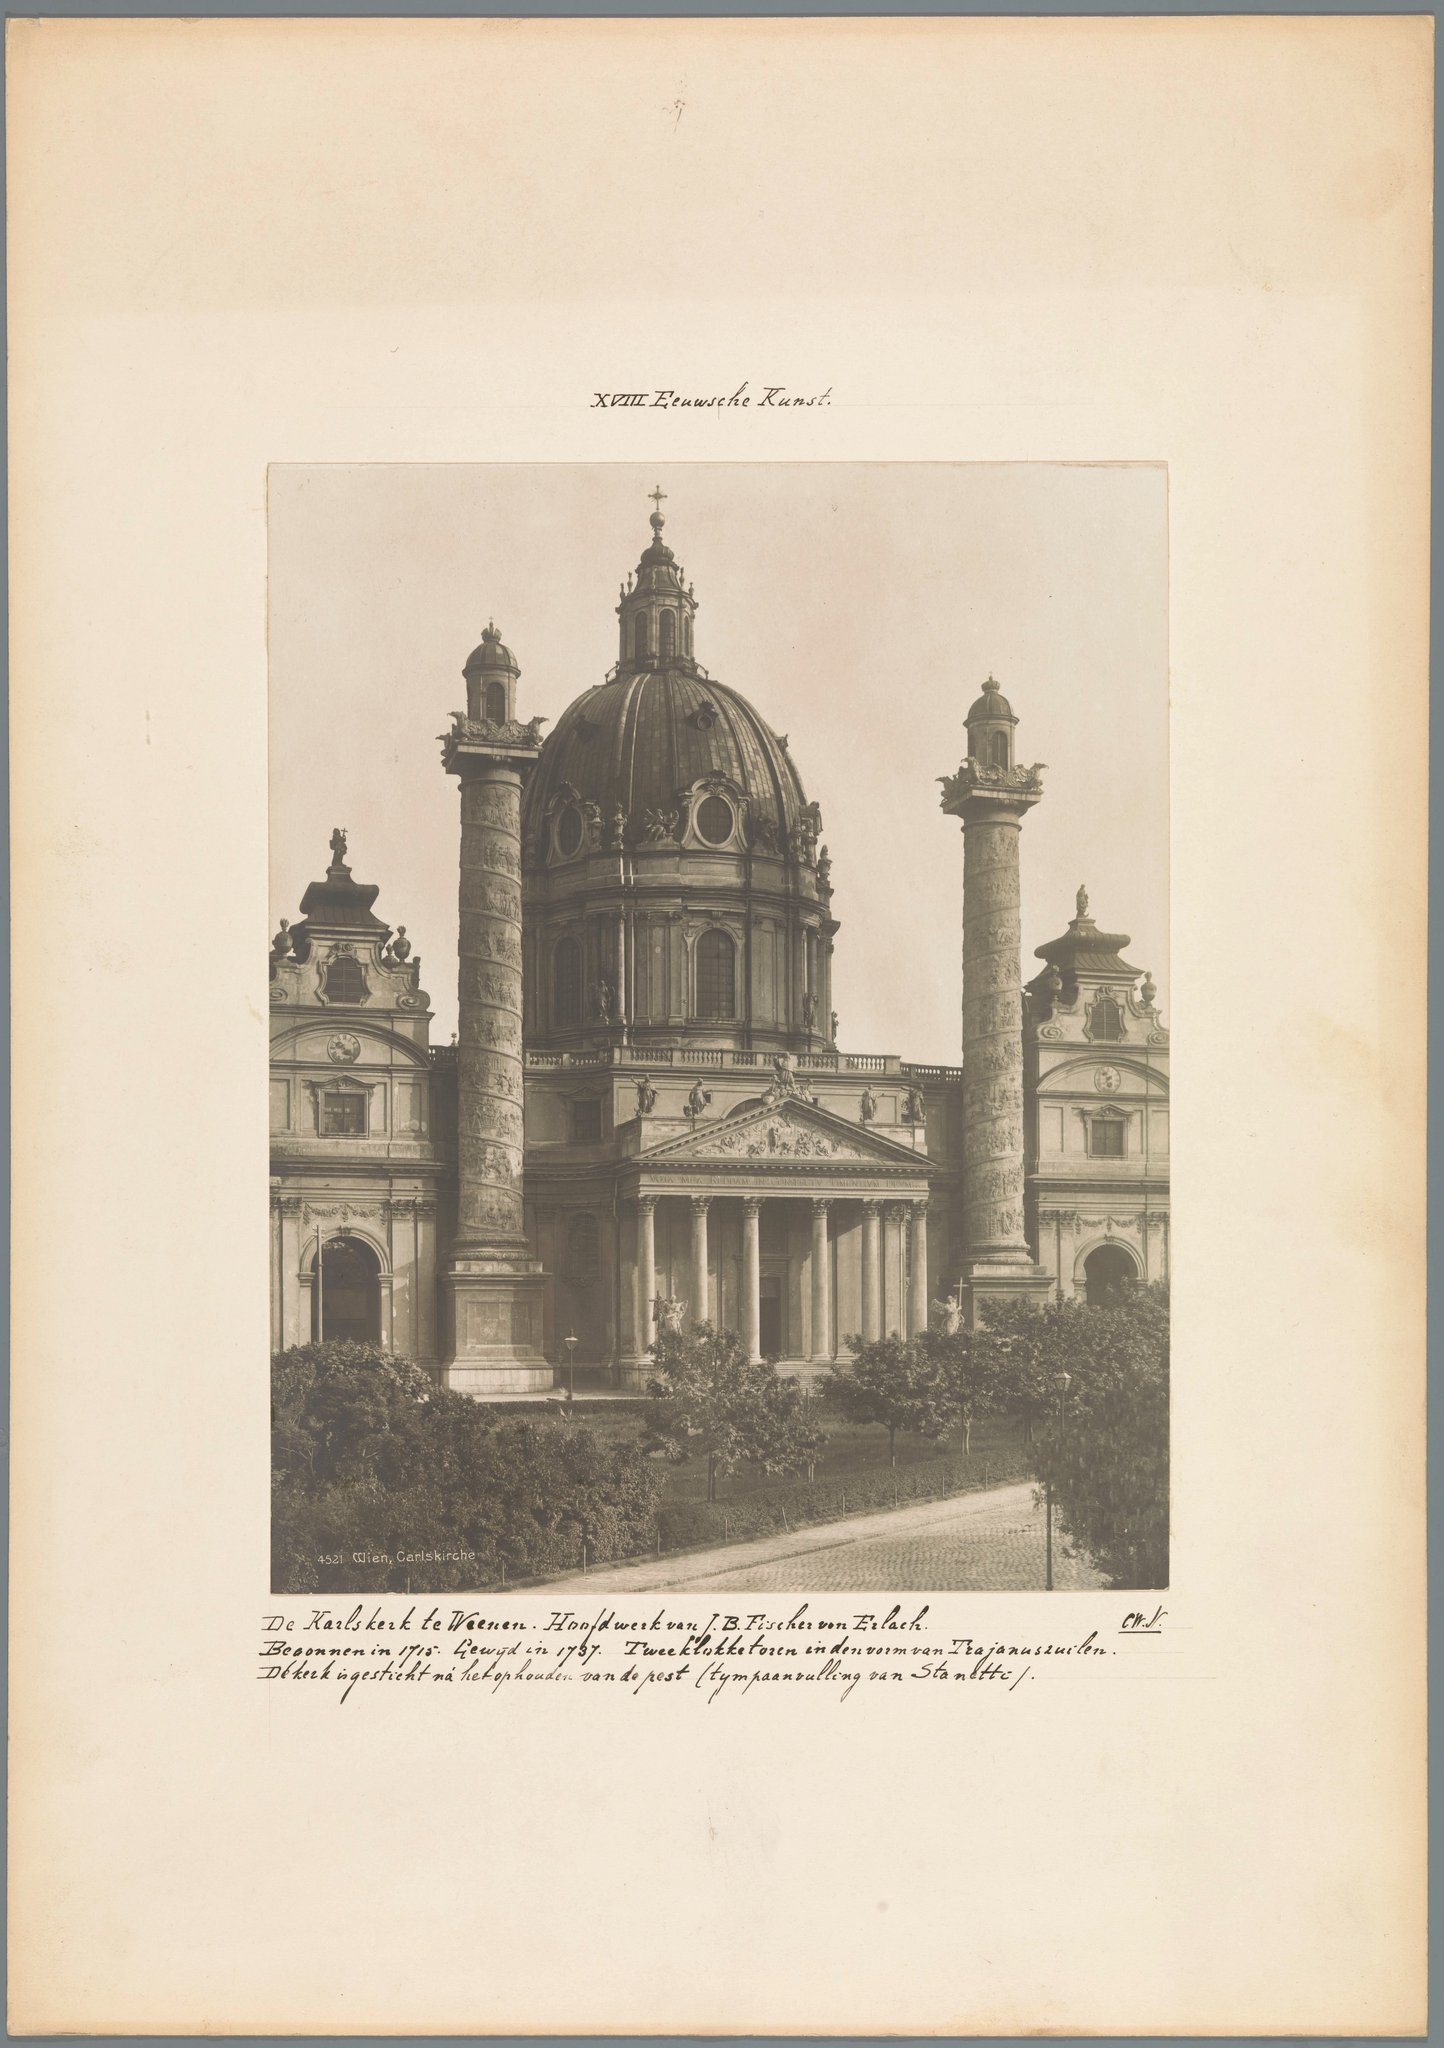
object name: photograph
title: Gezicht op de Karlskirche te Wenen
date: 1907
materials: cardboard, photographic support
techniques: daylight paper print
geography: vienna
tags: church (exterior), dome ~ architecture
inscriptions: number: ‘4521’, collector's mark: ‘KUNSTNIJVERHEIDSCHOOL QUELLINUS AMSTERDAM FRANS HALSSTRAAT 14.’, inscription: ‘C.W.N.’, inscription: ‘XVIII Eeuwsche Kunst.’, collector's mark: ‘INSTITUUT VOOR KUNST-NIJVERHEIDSONDERWIJS GABRIËL METSUSTRAAT No. 16 AMSTERDAM’, name: ‘[...] WIEN 1907’